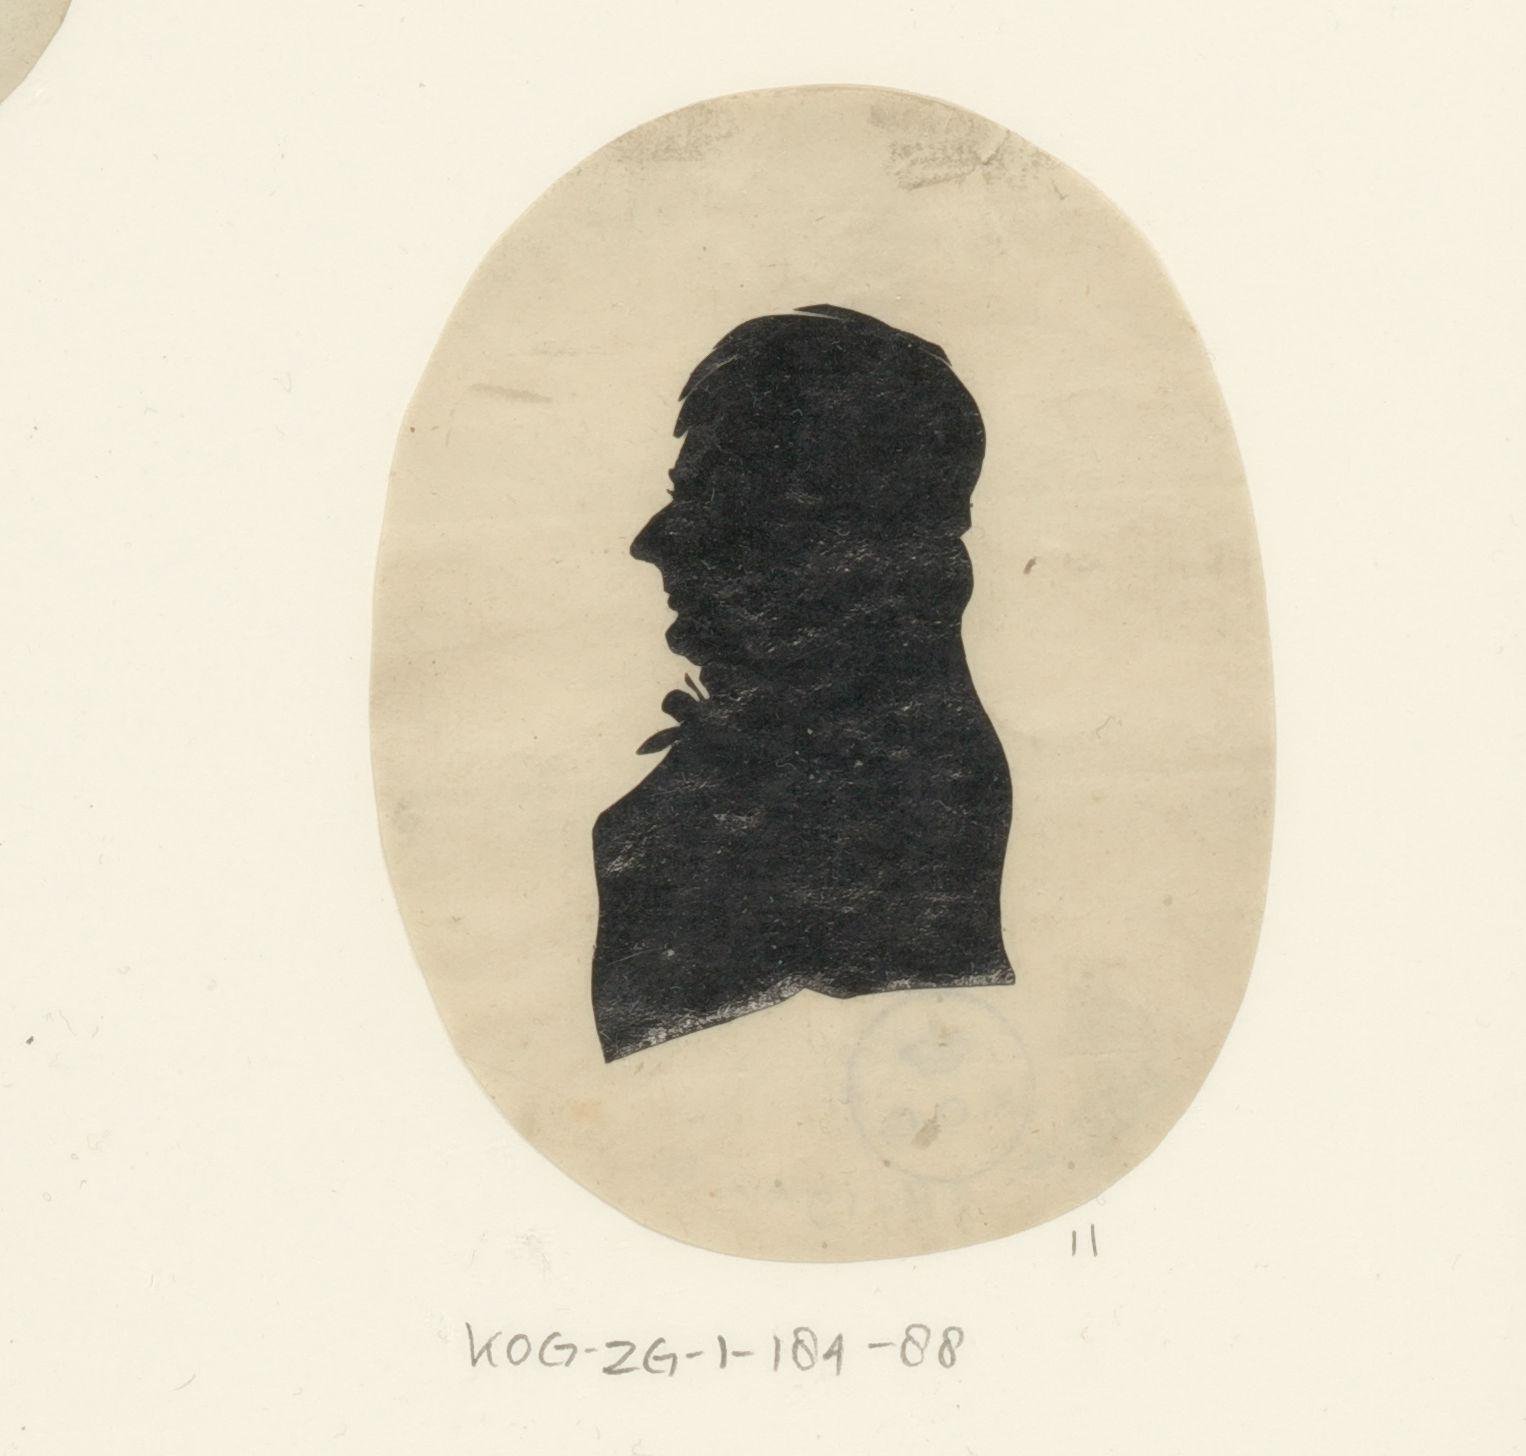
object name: silhouette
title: Silhouetportret van een onbekende man met pruik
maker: Anonymous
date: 1775-1849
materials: paper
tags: historical persons not known by name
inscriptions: stamp, collector's mark: Lugt 1641, collector's mark: Lugt 1641a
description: Hij draagt zijn haar naar voren gekamd. Een strikje onder de kin. Onderwerpsrubrieken binnen de Atlas Zeden en Gewoonten: Schoone kunsten, Silhouetportretten.